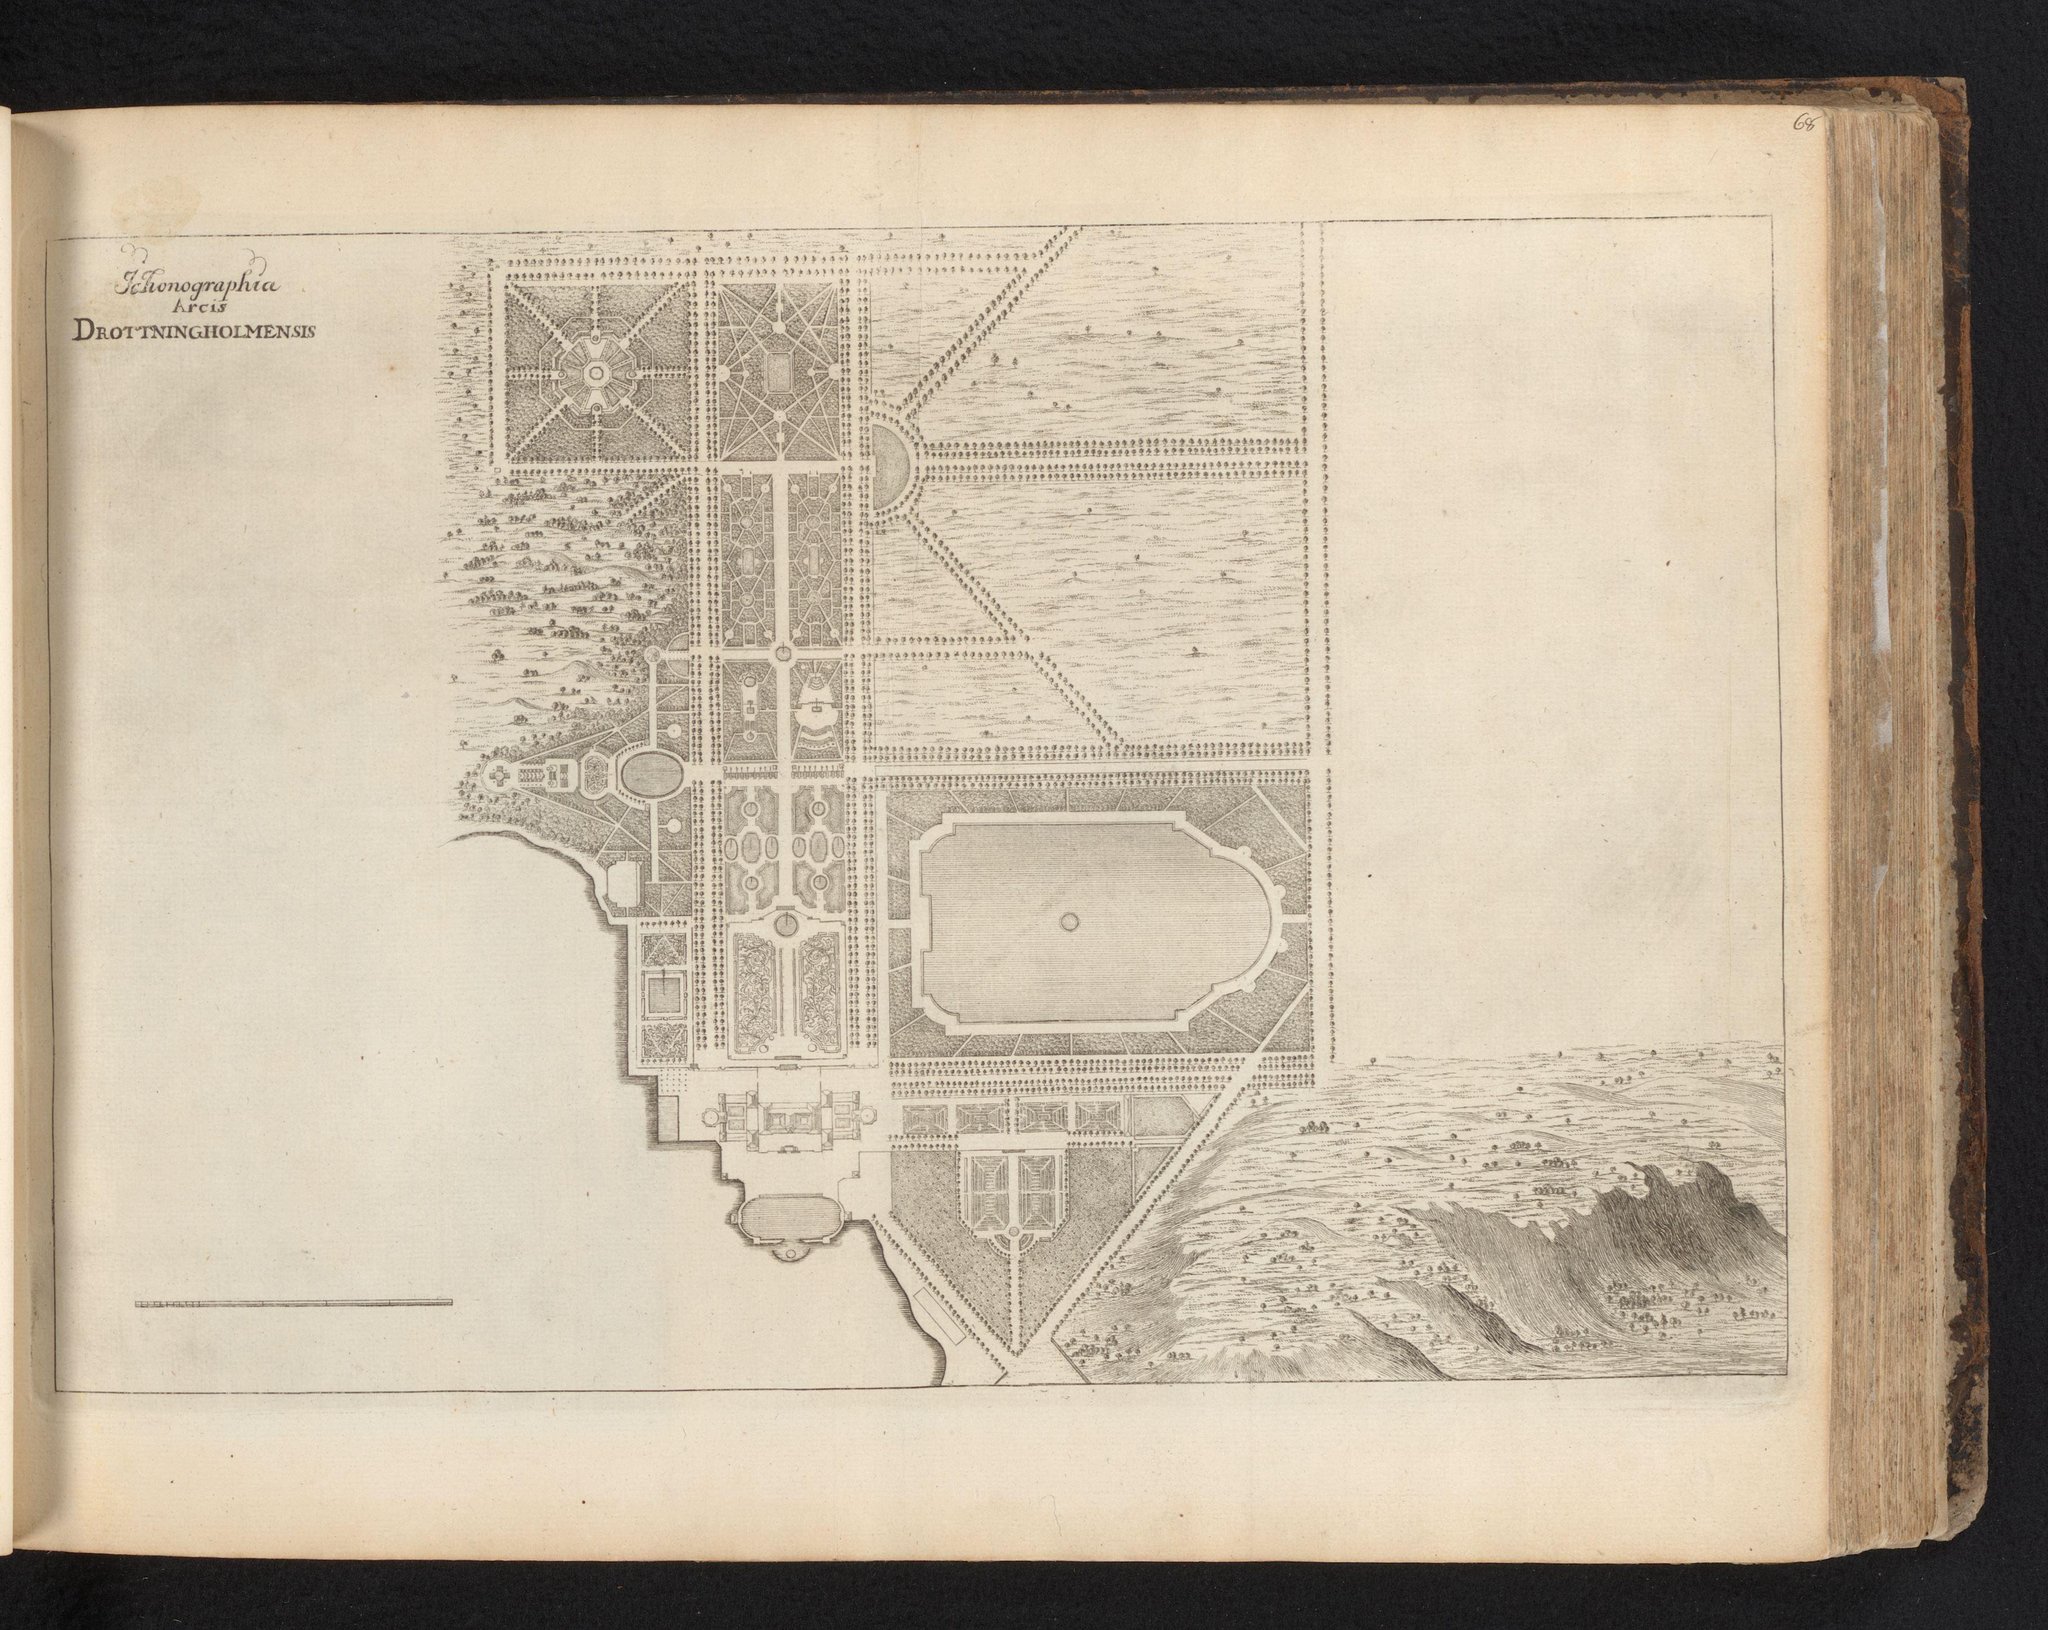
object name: album leaf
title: Suecia Antiqua et Hodierna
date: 1695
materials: paper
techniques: etching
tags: plan, map of garden, plan ~ architecture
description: Kungliga Biblioteket, 'Suecia': http://www.kb.se/samlingarna/Kartor-bilder/Suecia-antiqua/ (geraadpleegd november 2016).